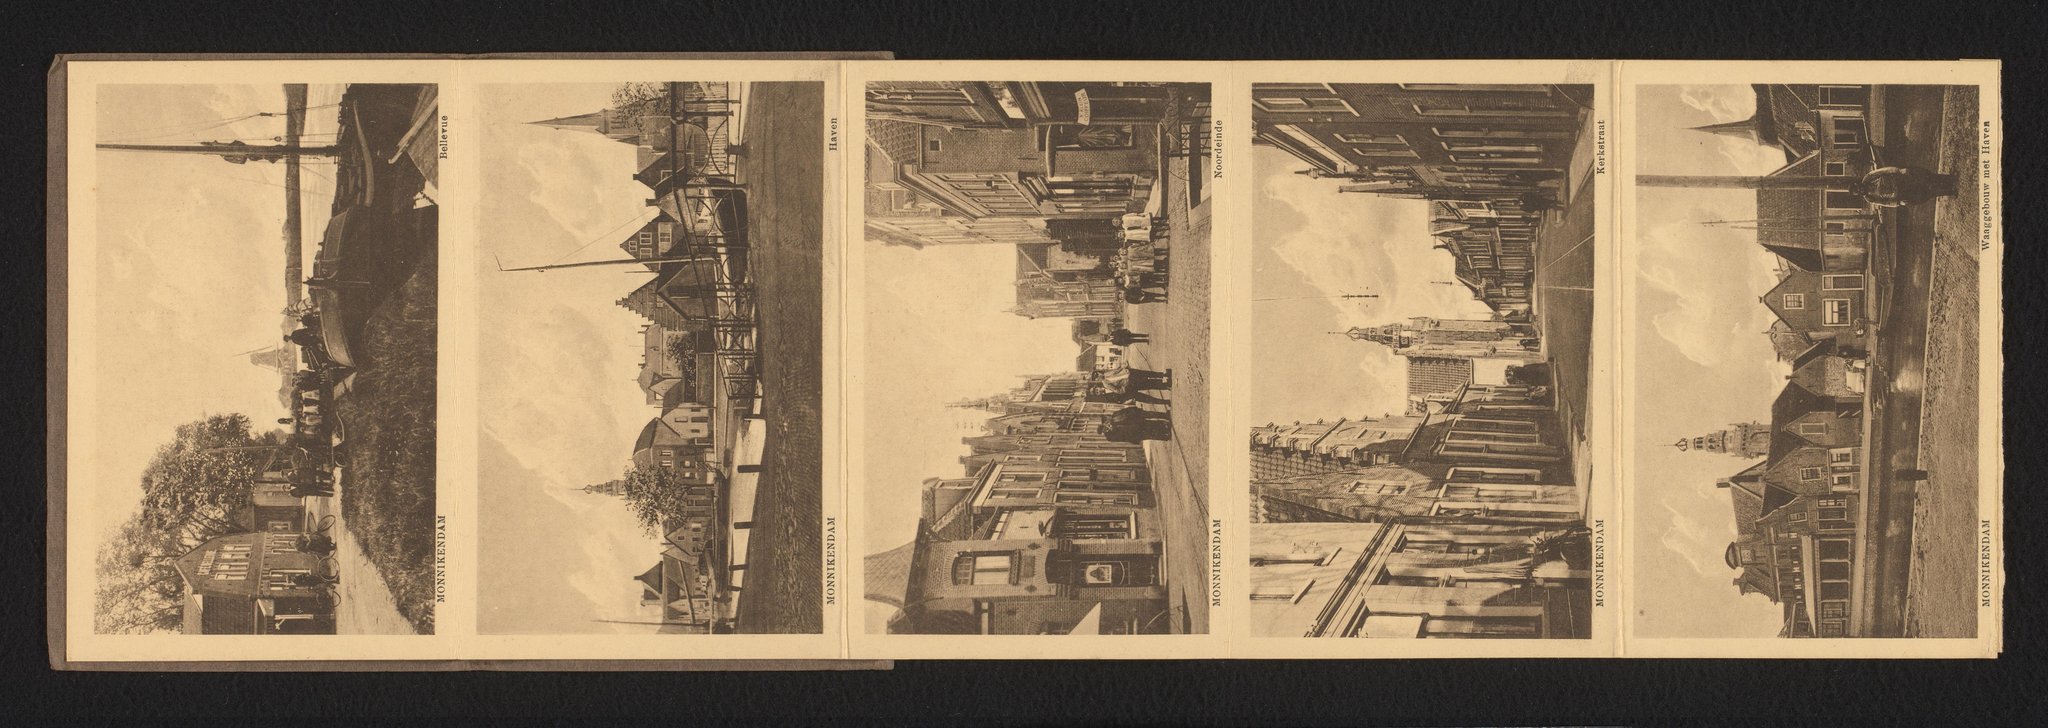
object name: accordion book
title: Leporelloalbum met voorstellingen van Monnickendam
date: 1920-1930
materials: cardboard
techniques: photograph, letterpress printing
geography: münchen-gladbach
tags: city-view, and landscape with man-made constructions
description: Leporelloalbum met vijf prentbriefkaarten van Monnickendam.